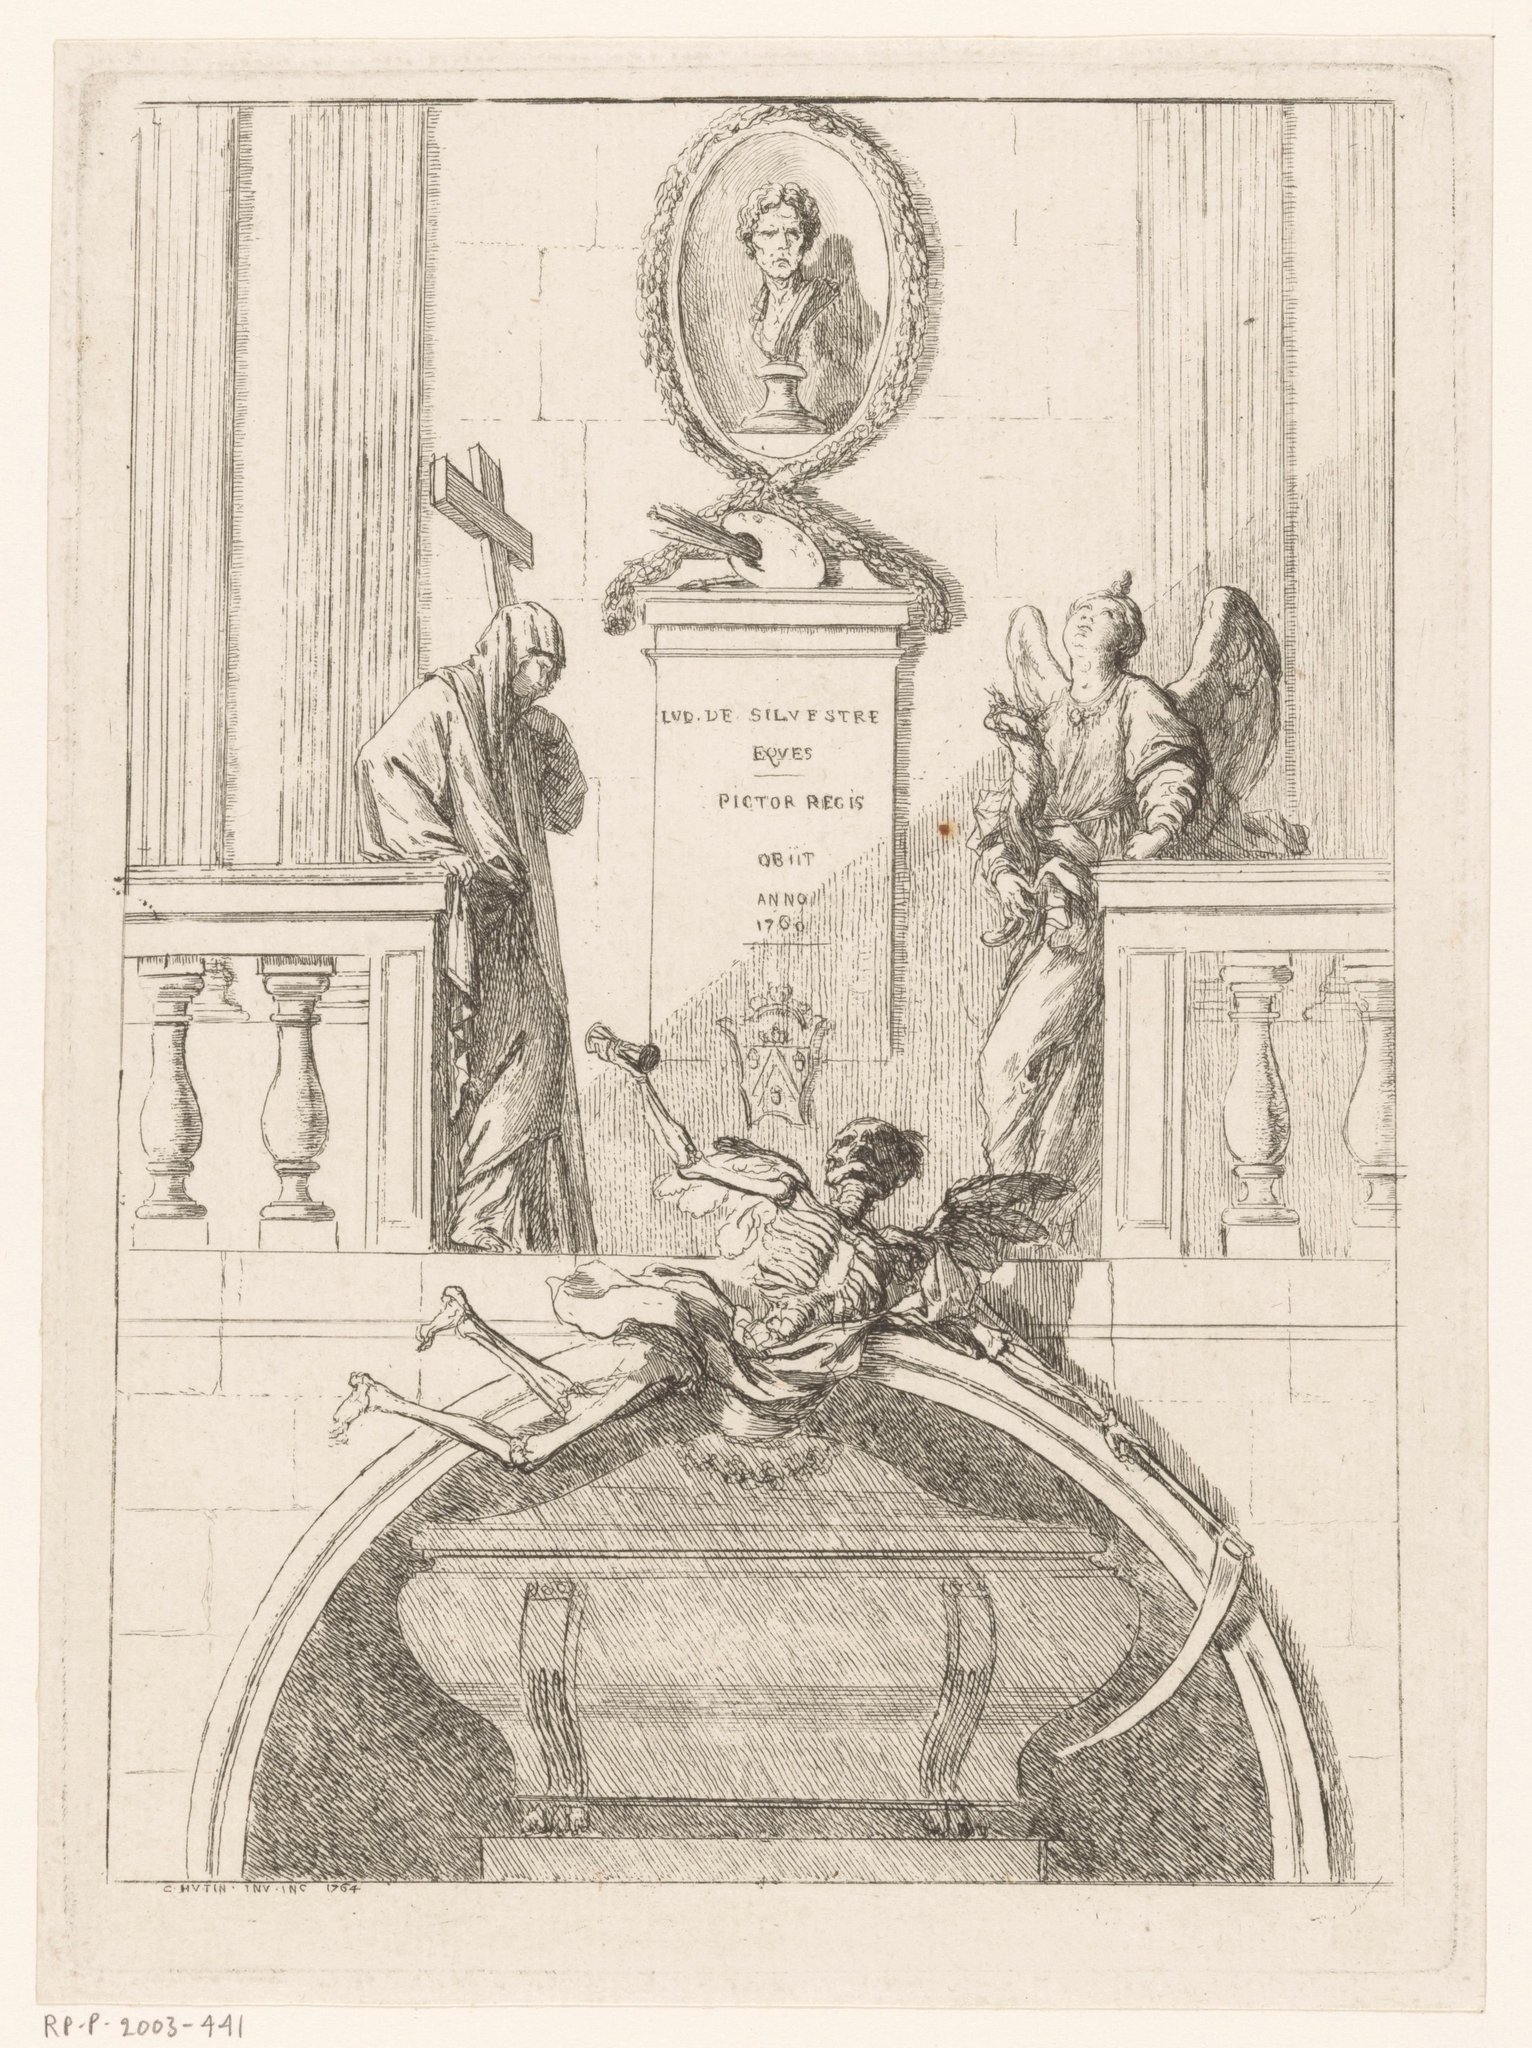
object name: print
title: Grafmonument voor Louis de Silvestre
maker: charles françois hutin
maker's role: draughtsman, print maker, sculptor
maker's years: 1715-1776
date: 1764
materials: paper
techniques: etching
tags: grave, tomb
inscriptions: collector's mark: Lugt 2228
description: Grafmonument voor de kunstenaar Louis de Silvestre. Zijn naam staat op de opstaande grafsteen, waarboven een palet met penselen en zijn portret met lauwerkrans. Op een balustrade naast de steen staan links een vrouw met een kruis en rechts een engel met hoorn des overvloeds. Midden onder ligt de Dood als een skelet voor het graf boven een doodskist.